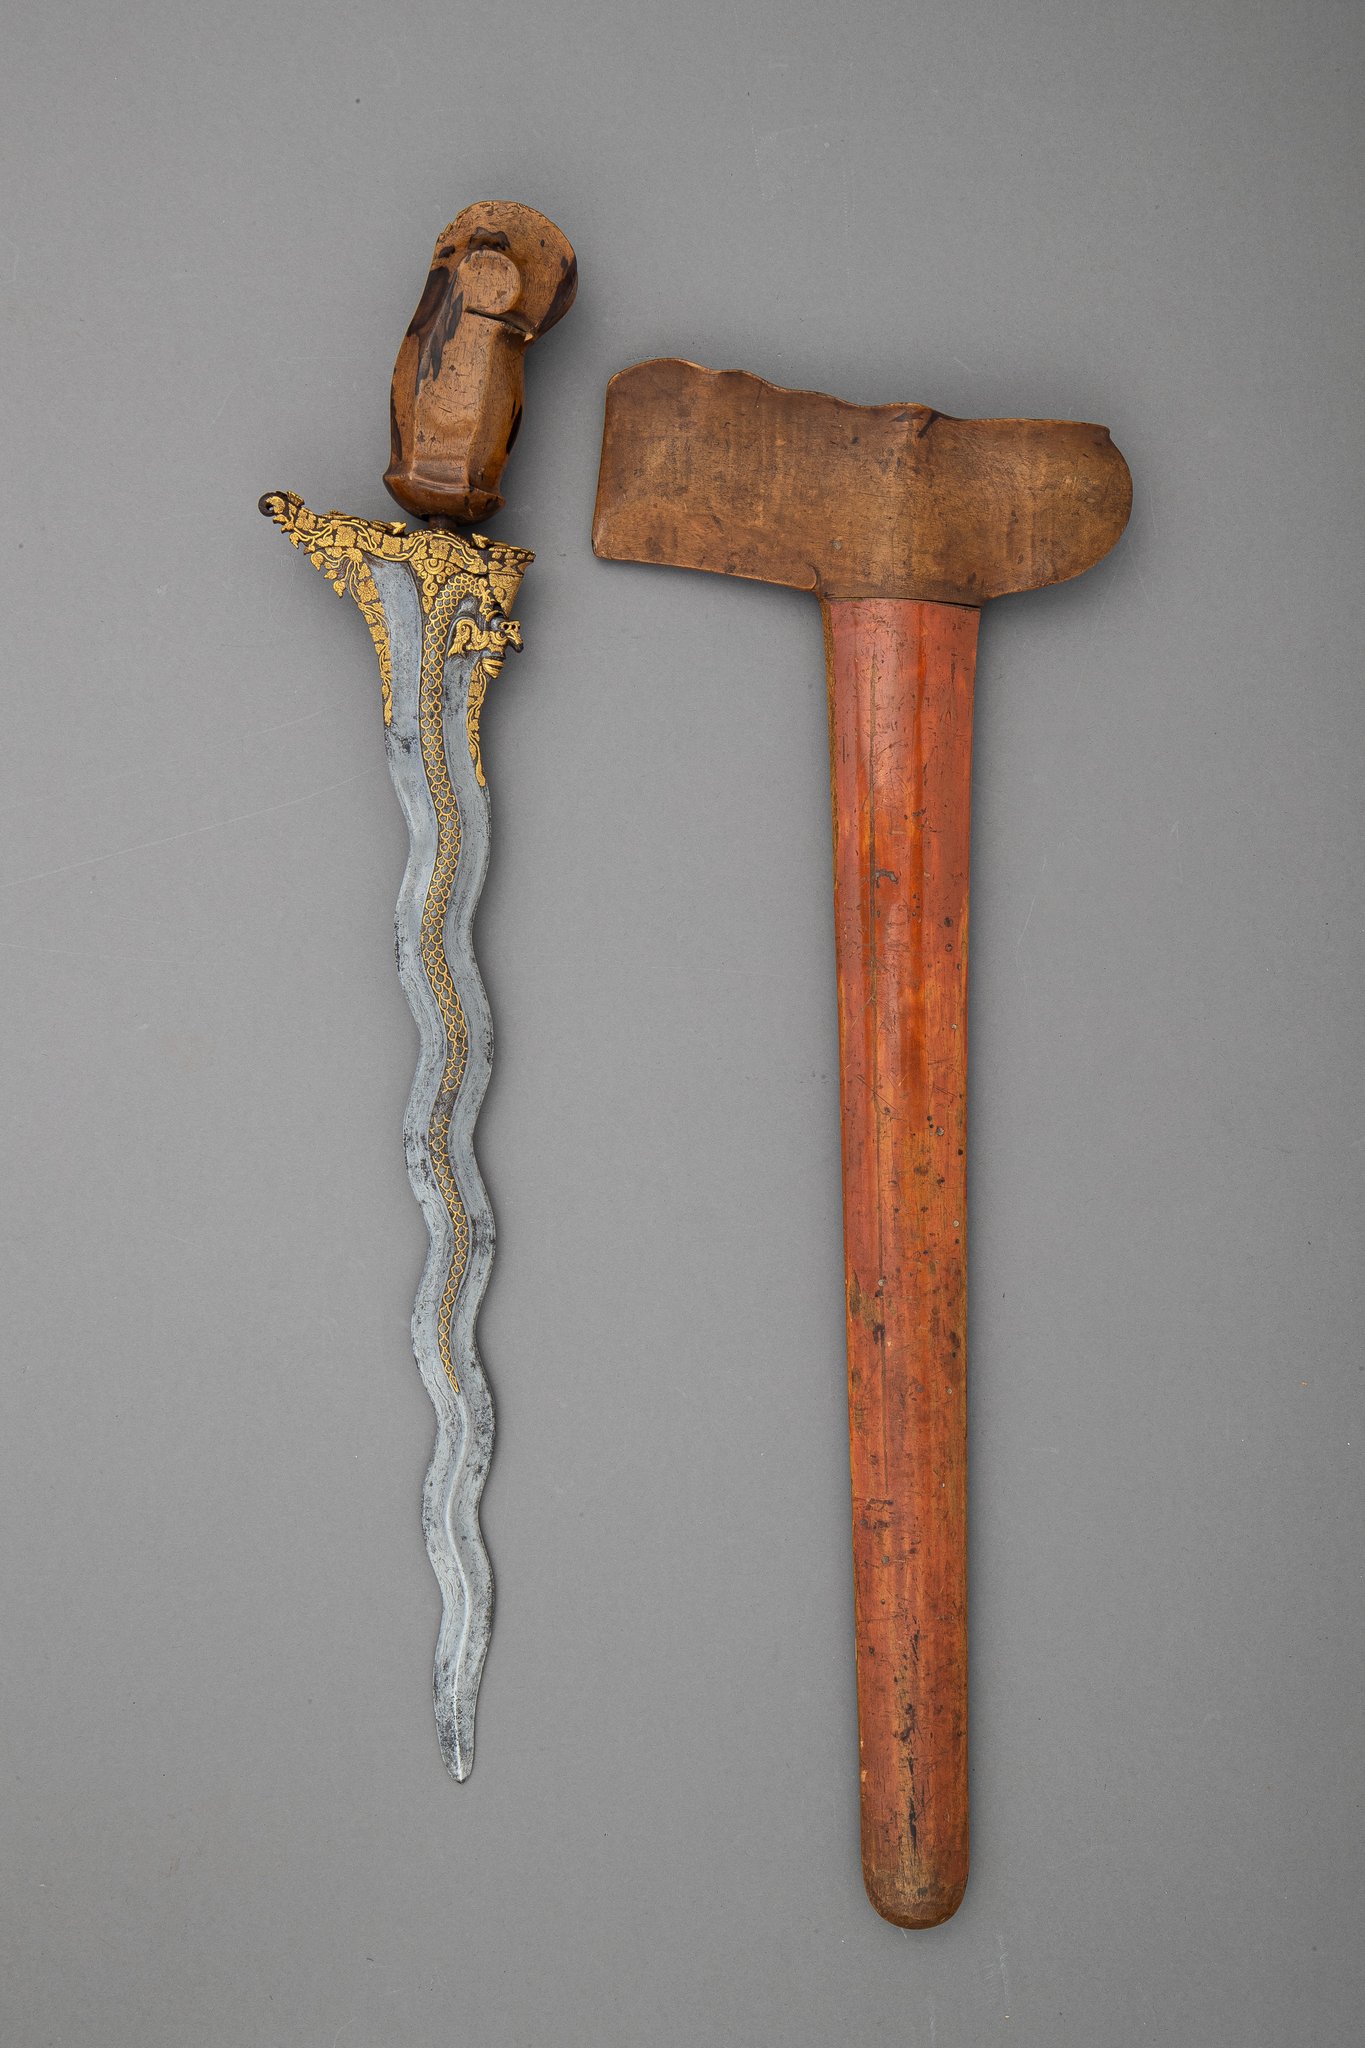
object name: kris with sheath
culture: balinese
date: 1501-1900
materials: gold, steel, wood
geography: indonesia